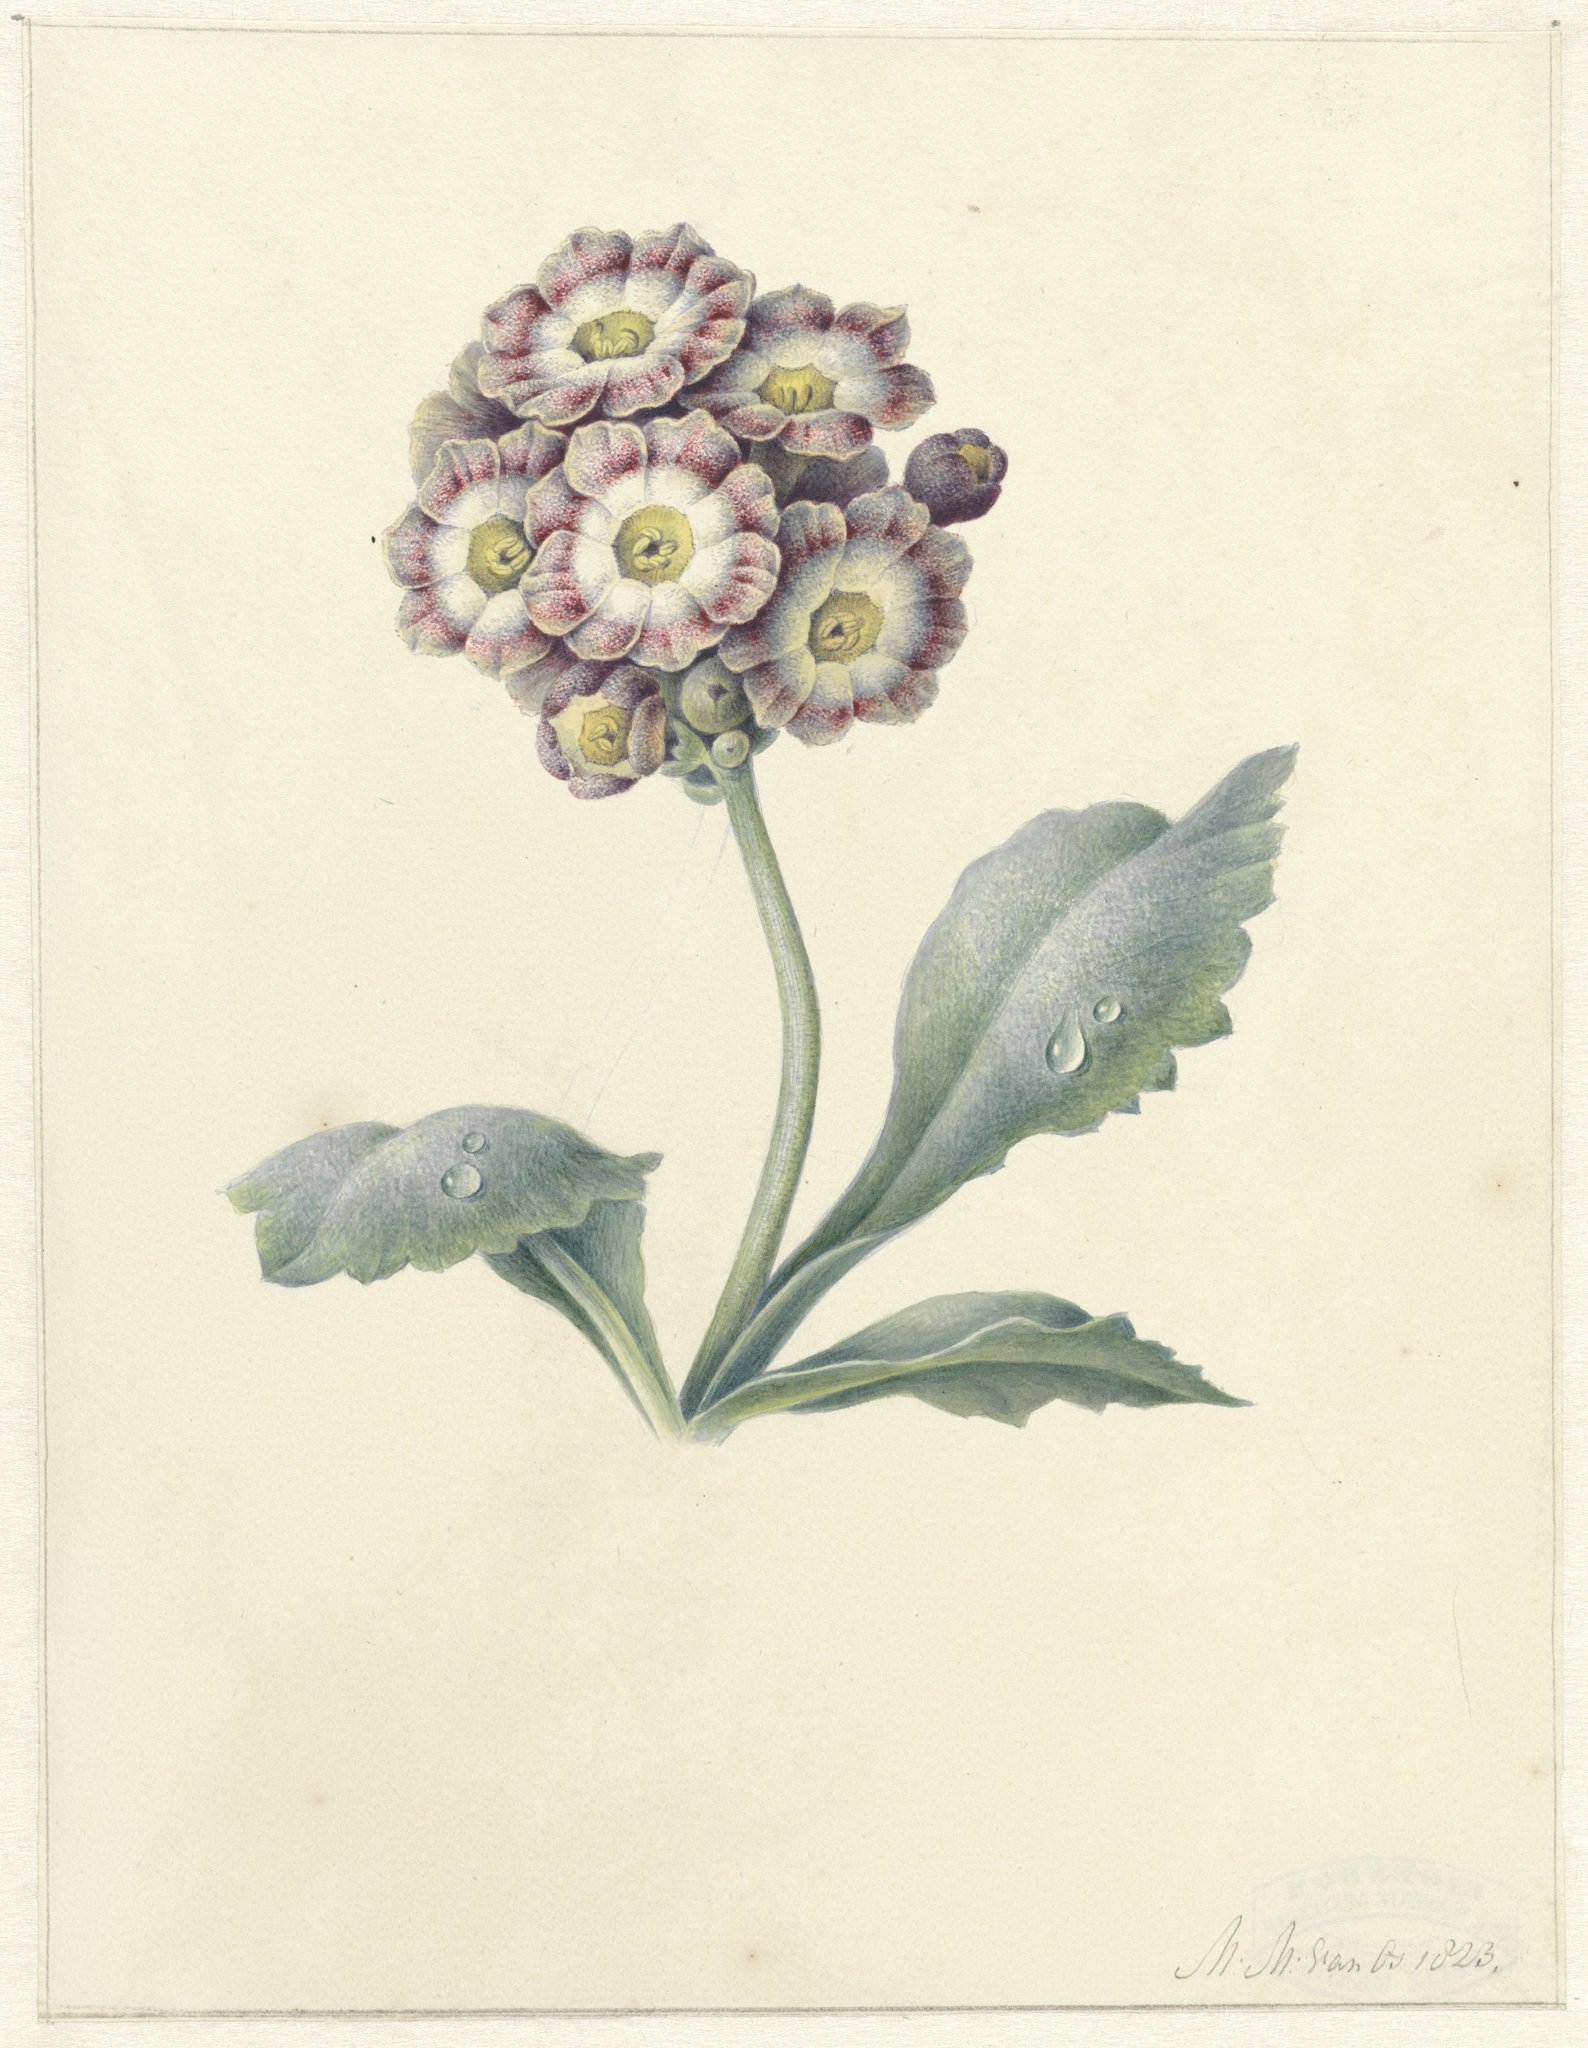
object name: watercolor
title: Bloemenstudie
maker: maria margaretha van os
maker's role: draughtsman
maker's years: 1780-1862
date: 1823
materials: paper, watercolor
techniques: brush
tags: flowers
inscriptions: date: ‘1823’